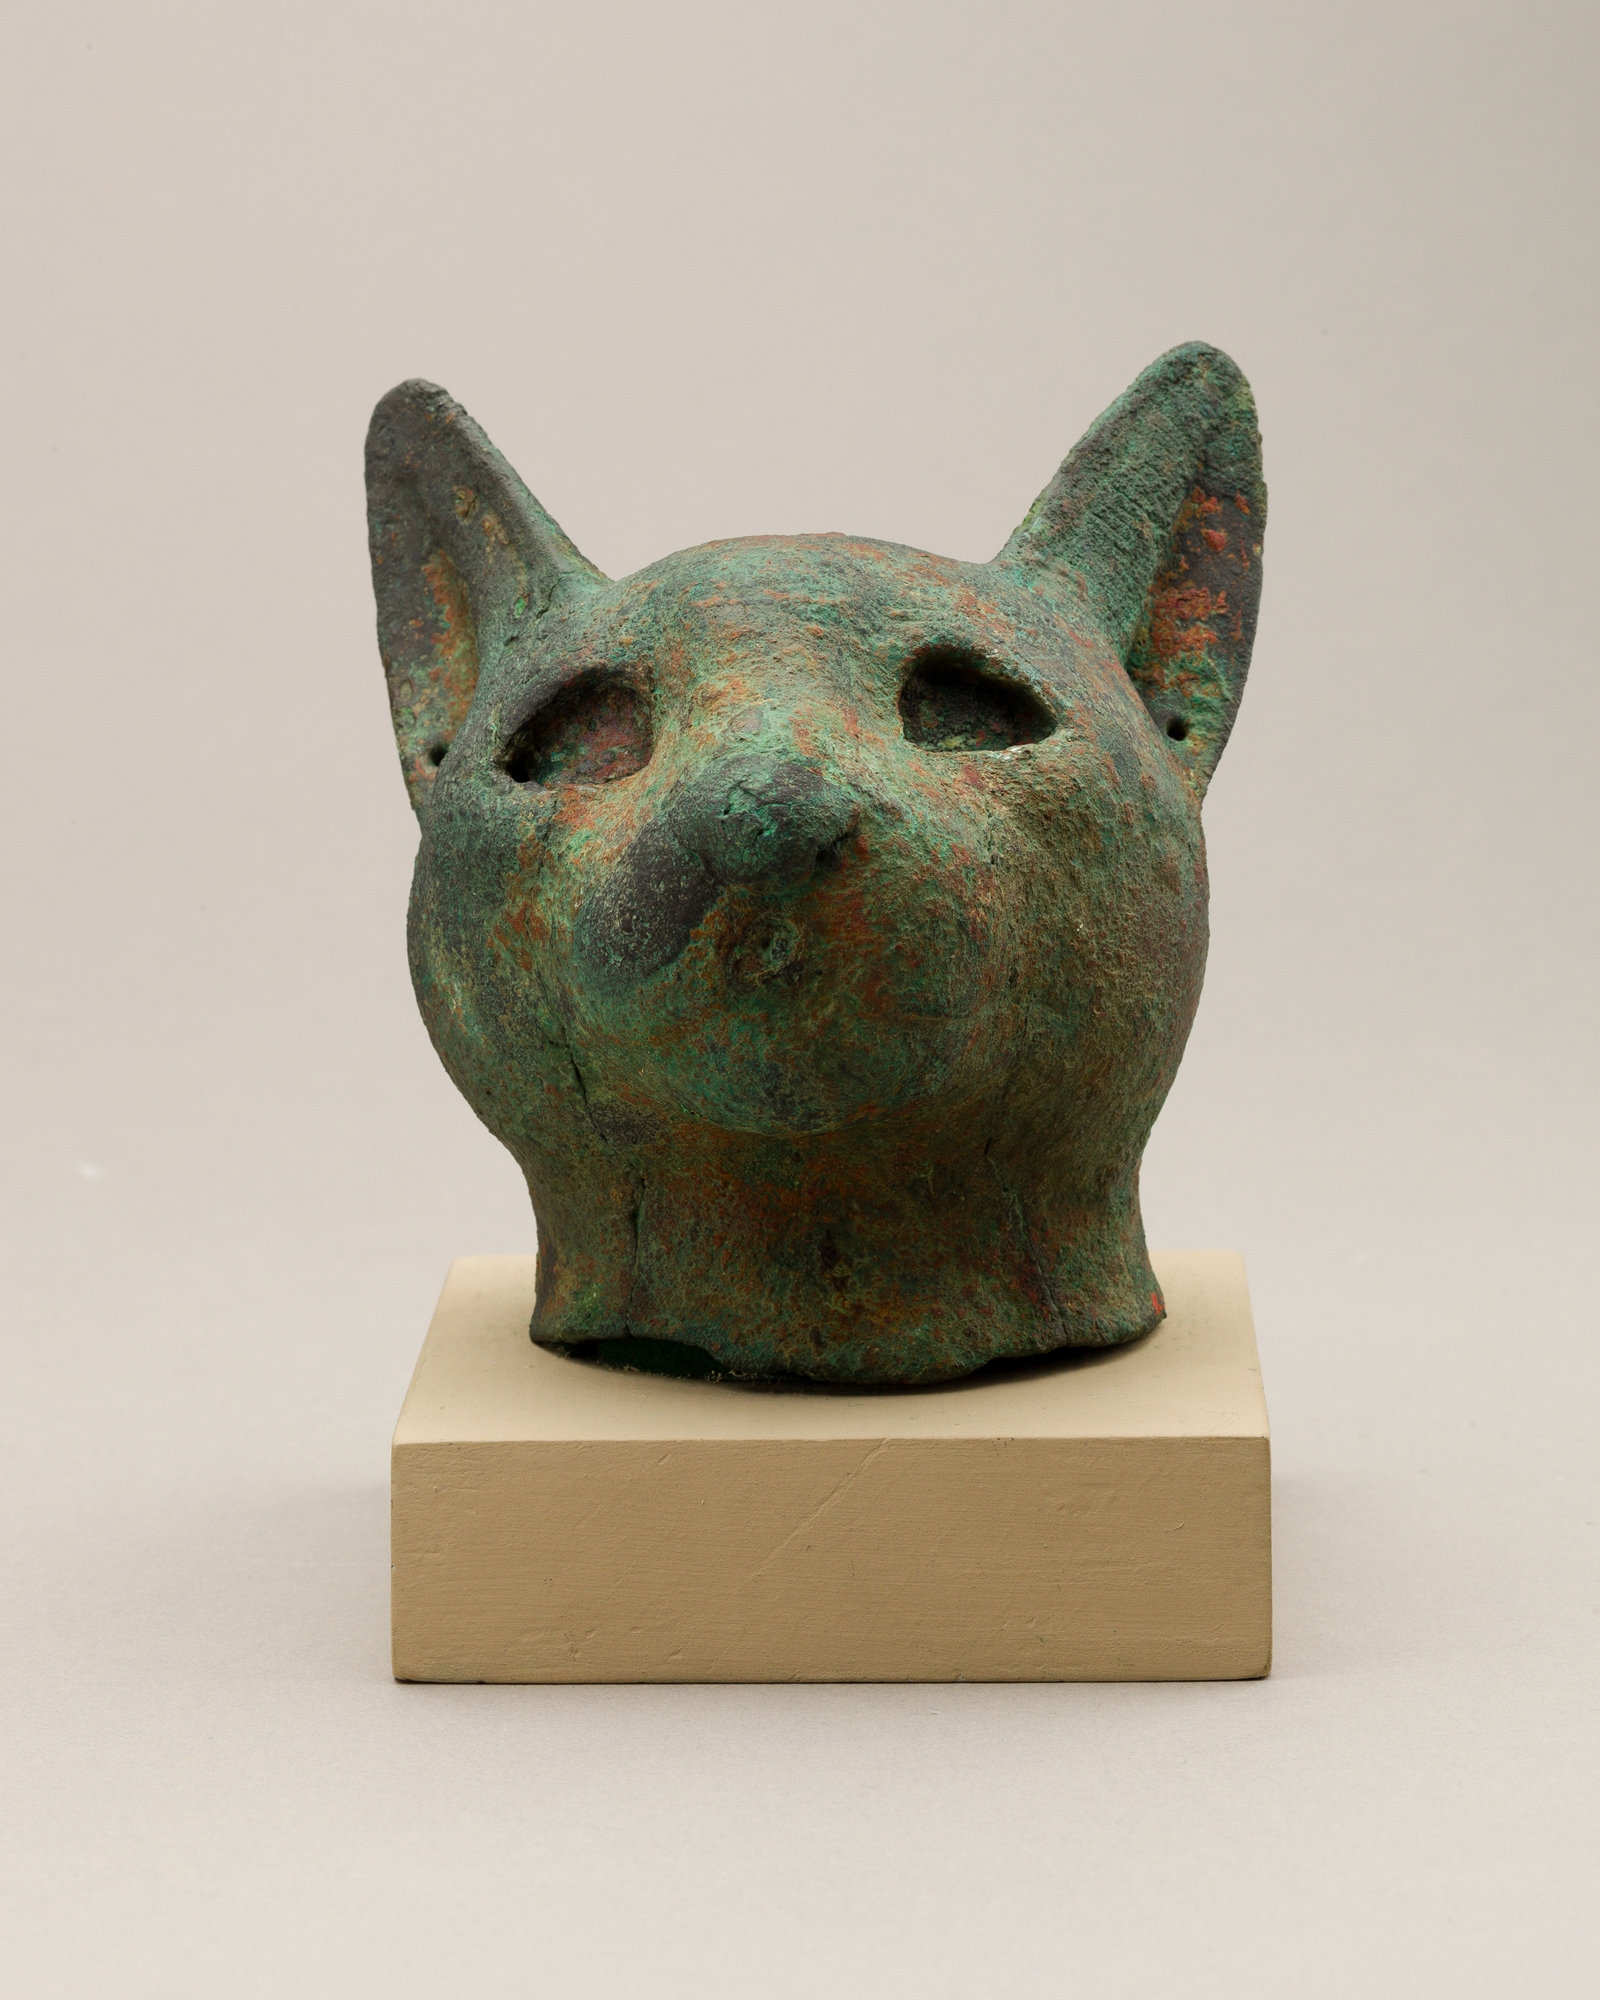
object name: head, cat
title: Head of a cat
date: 664-630 BCE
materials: metal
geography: egypt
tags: cats